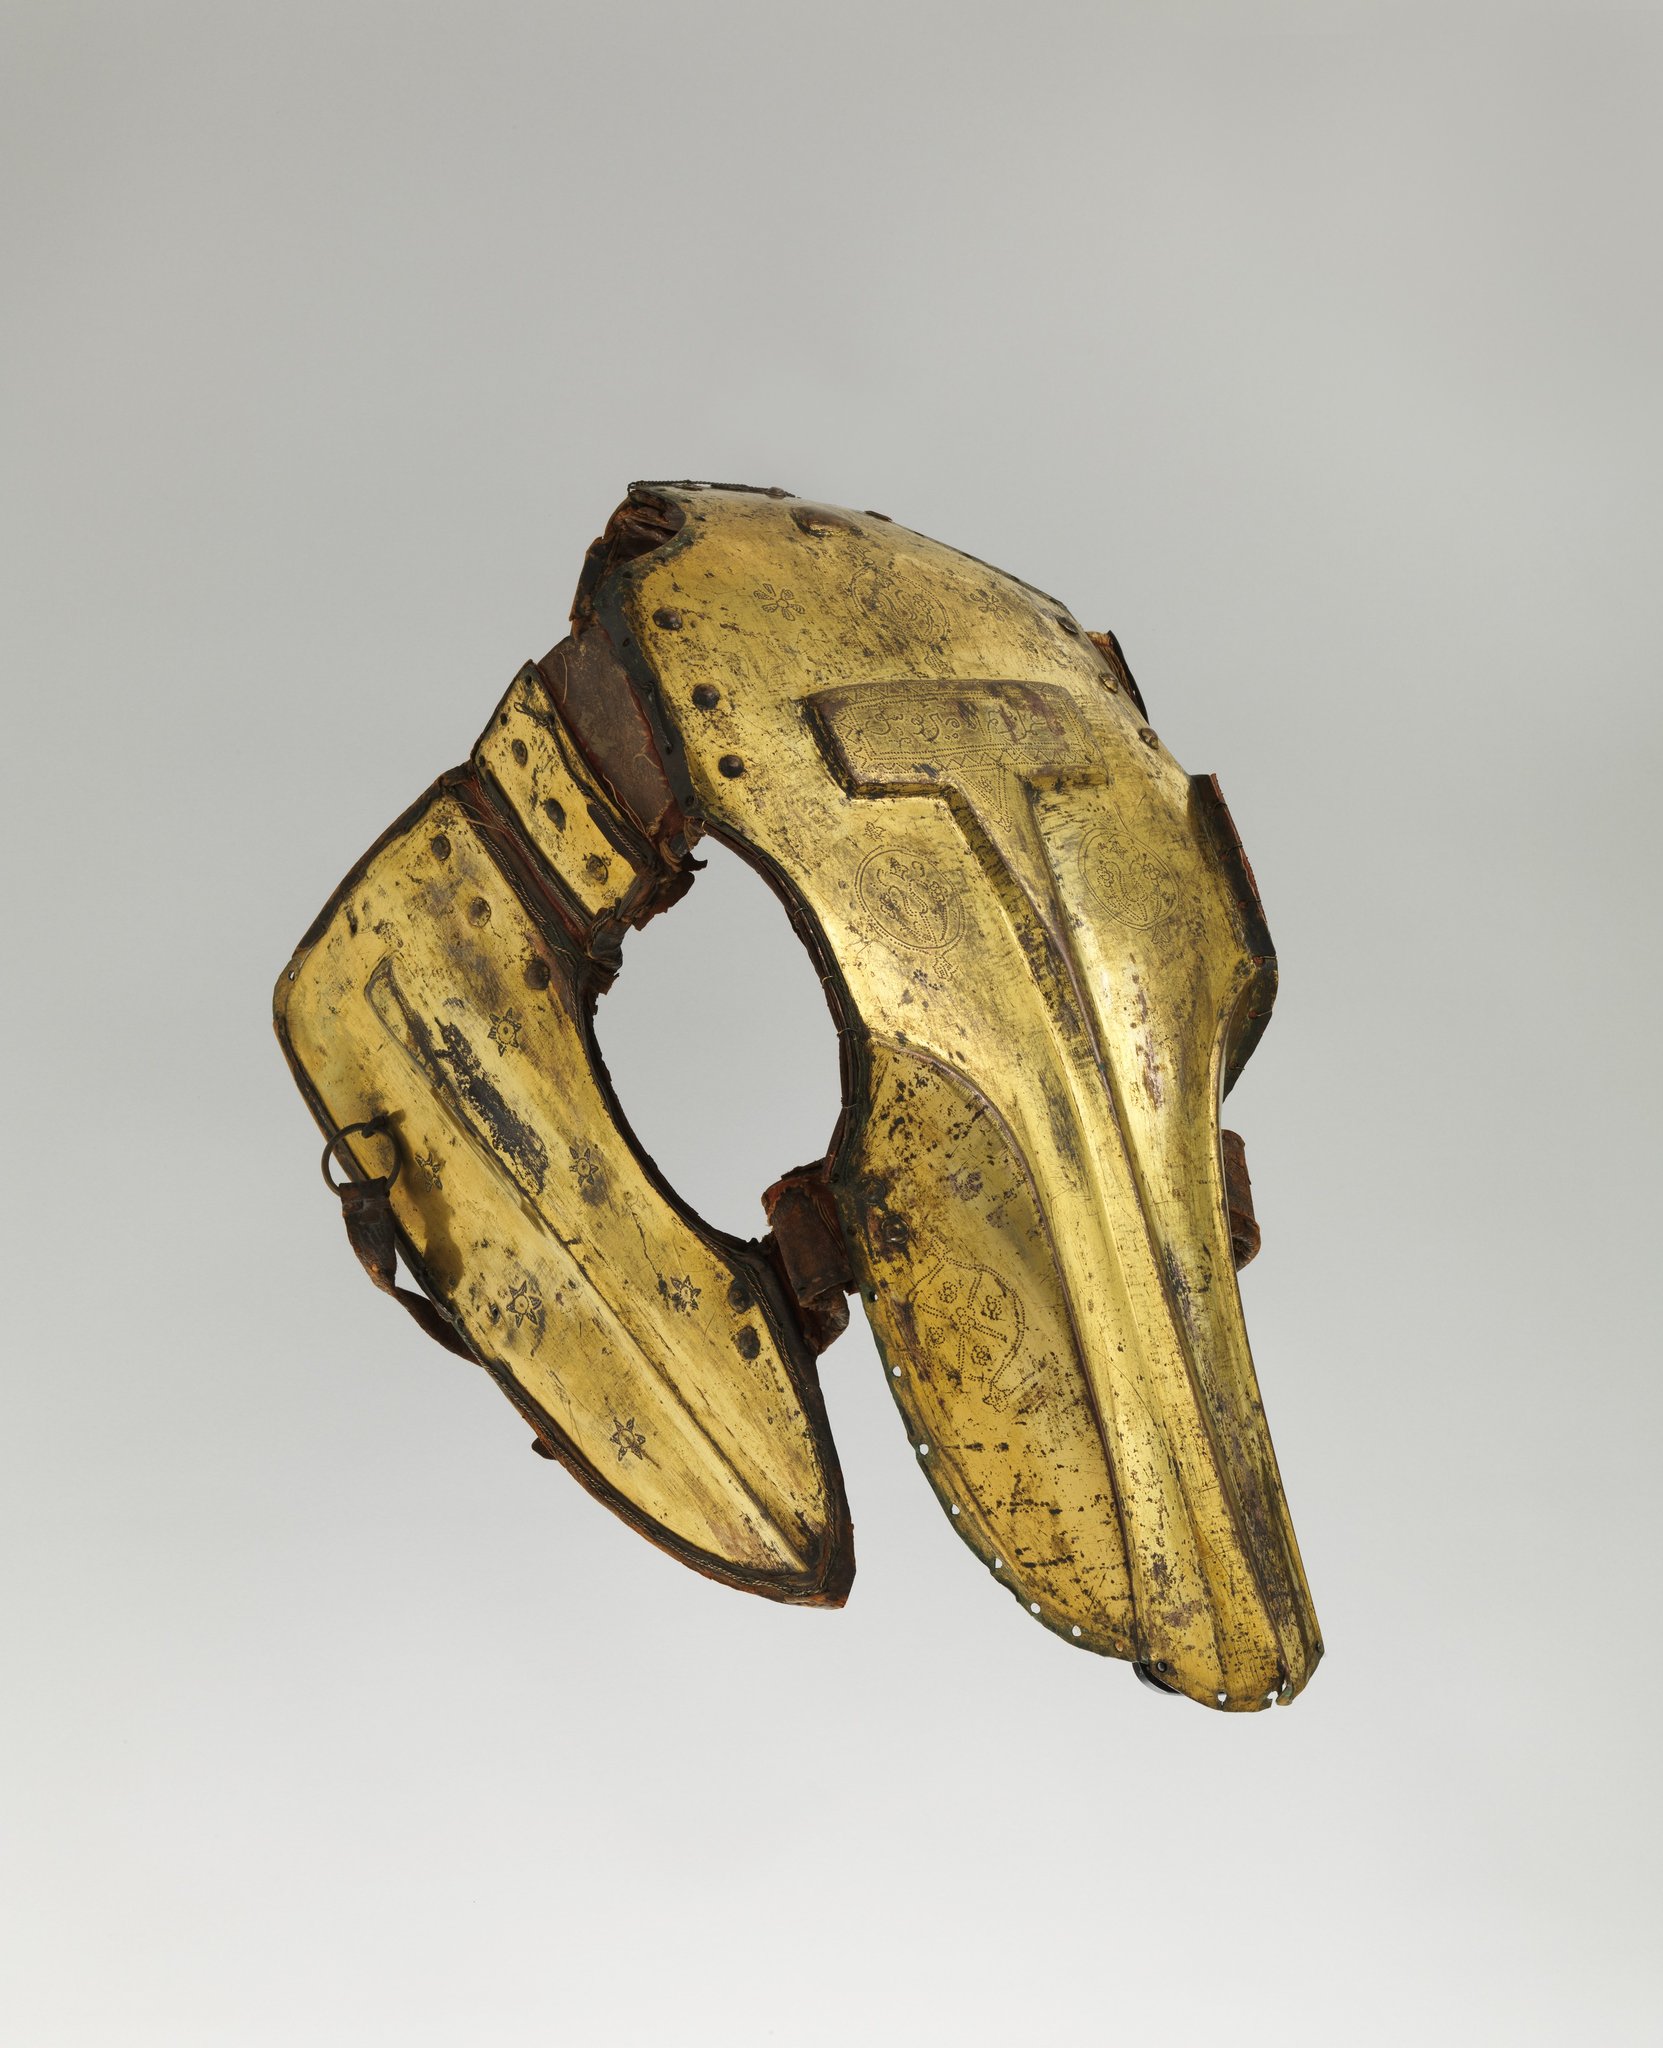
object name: shaffron horse's head defense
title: Shaffron (Horse's Head Defense)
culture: turkish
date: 1601-1700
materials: copper alloy, gold, leather, textile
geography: turkey